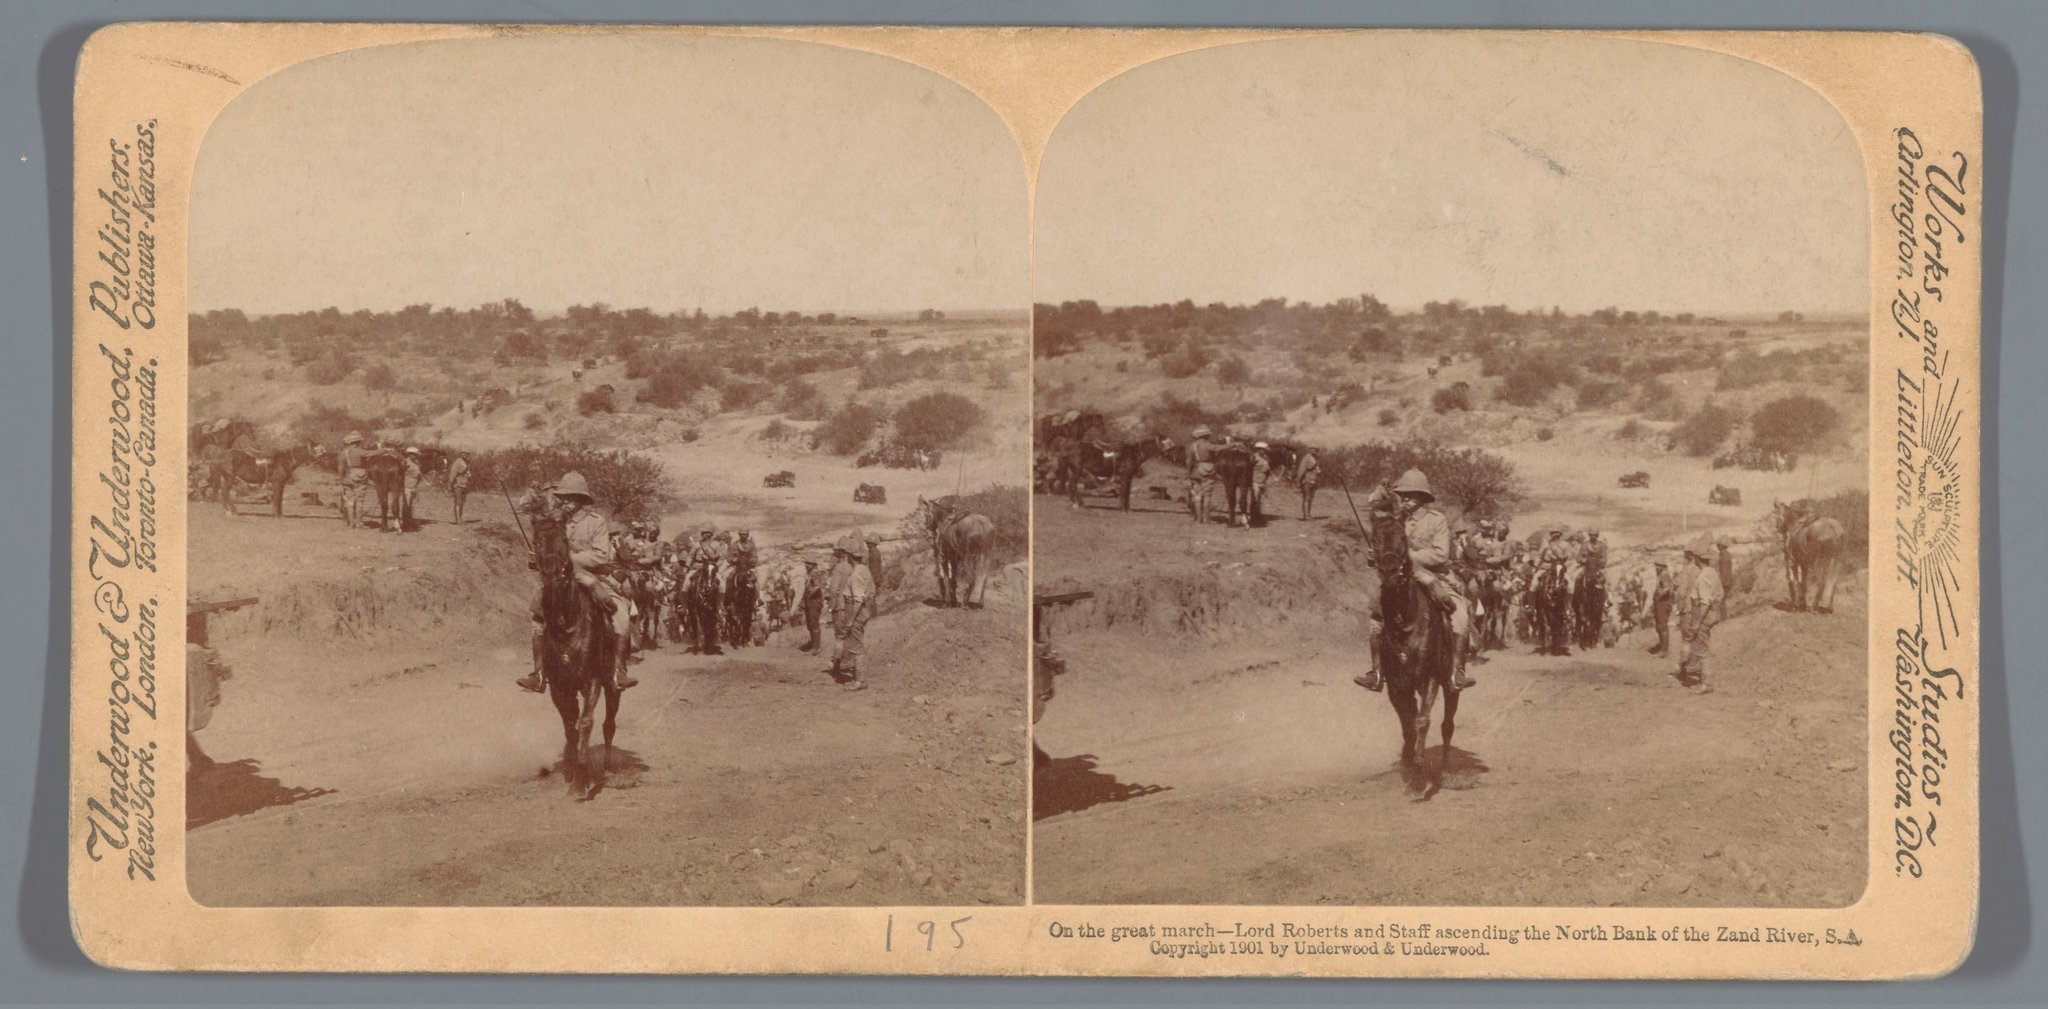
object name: stereograph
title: On the great march, Lord Roberts and Staff ascending the North Bank of the Zand River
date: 1901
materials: cardboard, photographic support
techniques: albumen print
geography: south africa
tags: army 'en route'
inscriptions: number: ‘195’, name: ‘Works and Studios Sun Sculpture trade mark Arlington N.J. Littleton N.H. Washington D.C.’